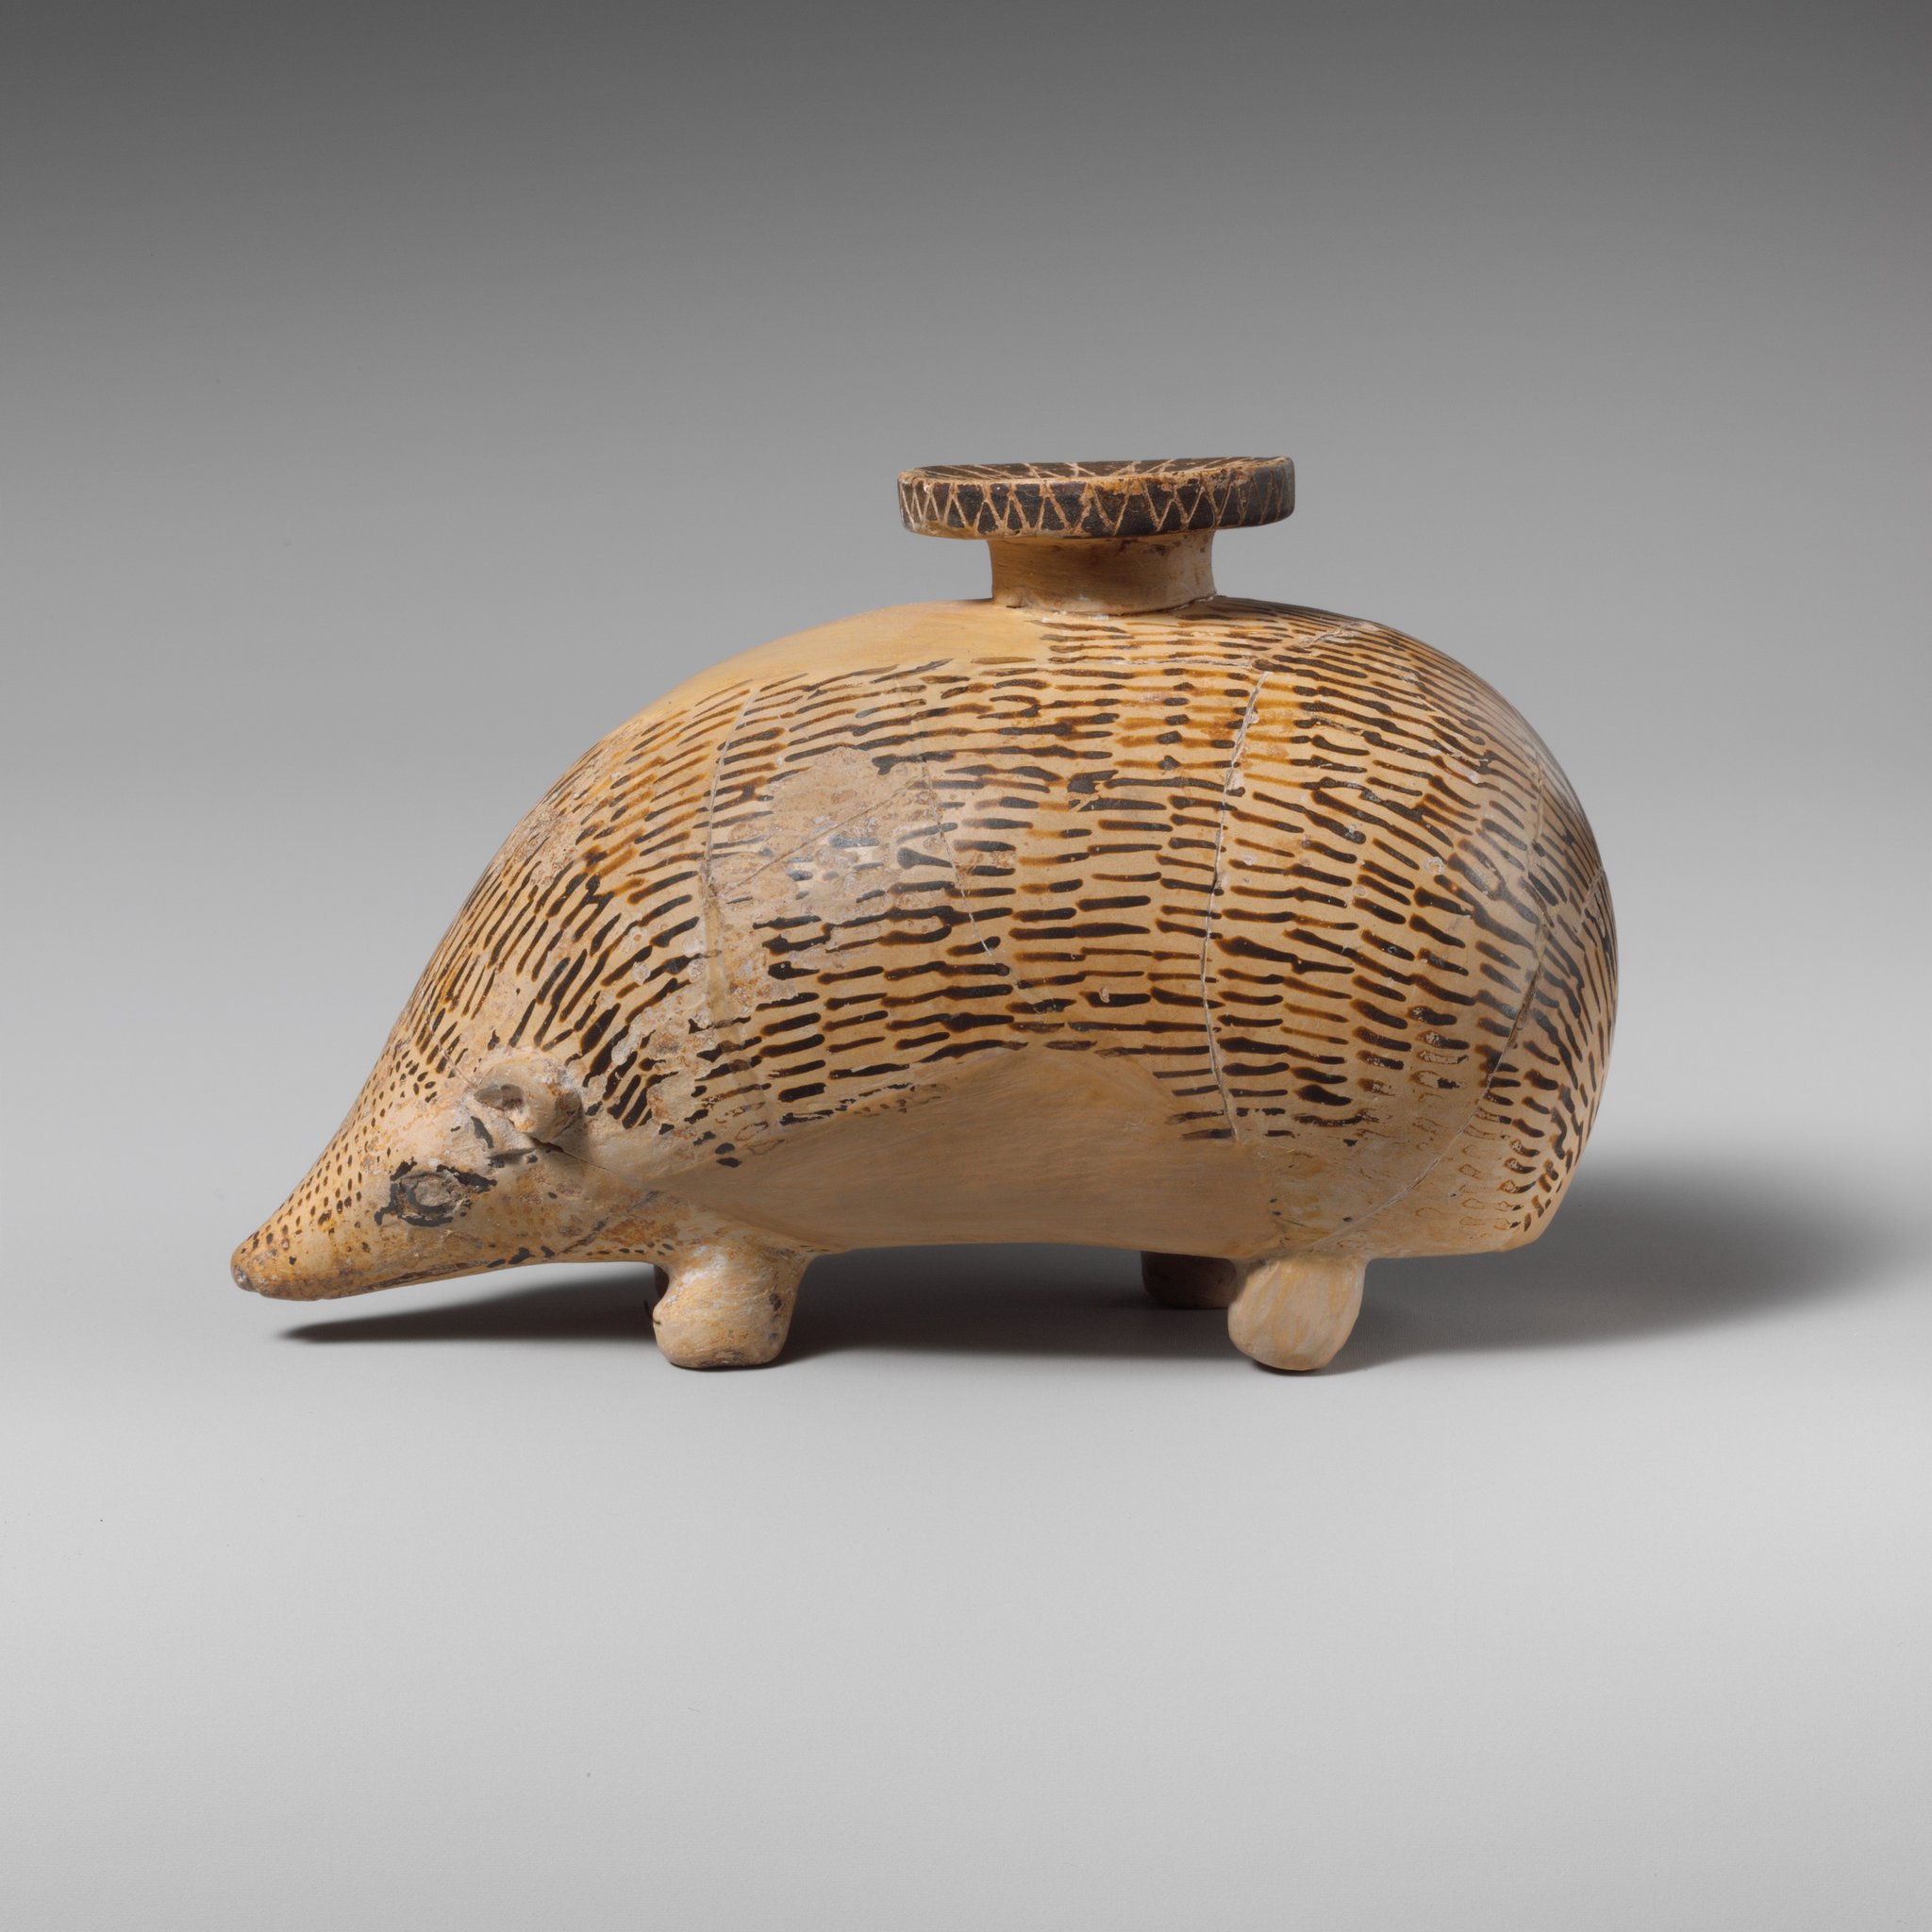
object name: vase, hedgehog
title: Terracotta aryballos (perfume vase) in the form of a hedgehog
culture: rhodian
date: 567-535 BCE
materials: terracotta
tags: hedgehogs